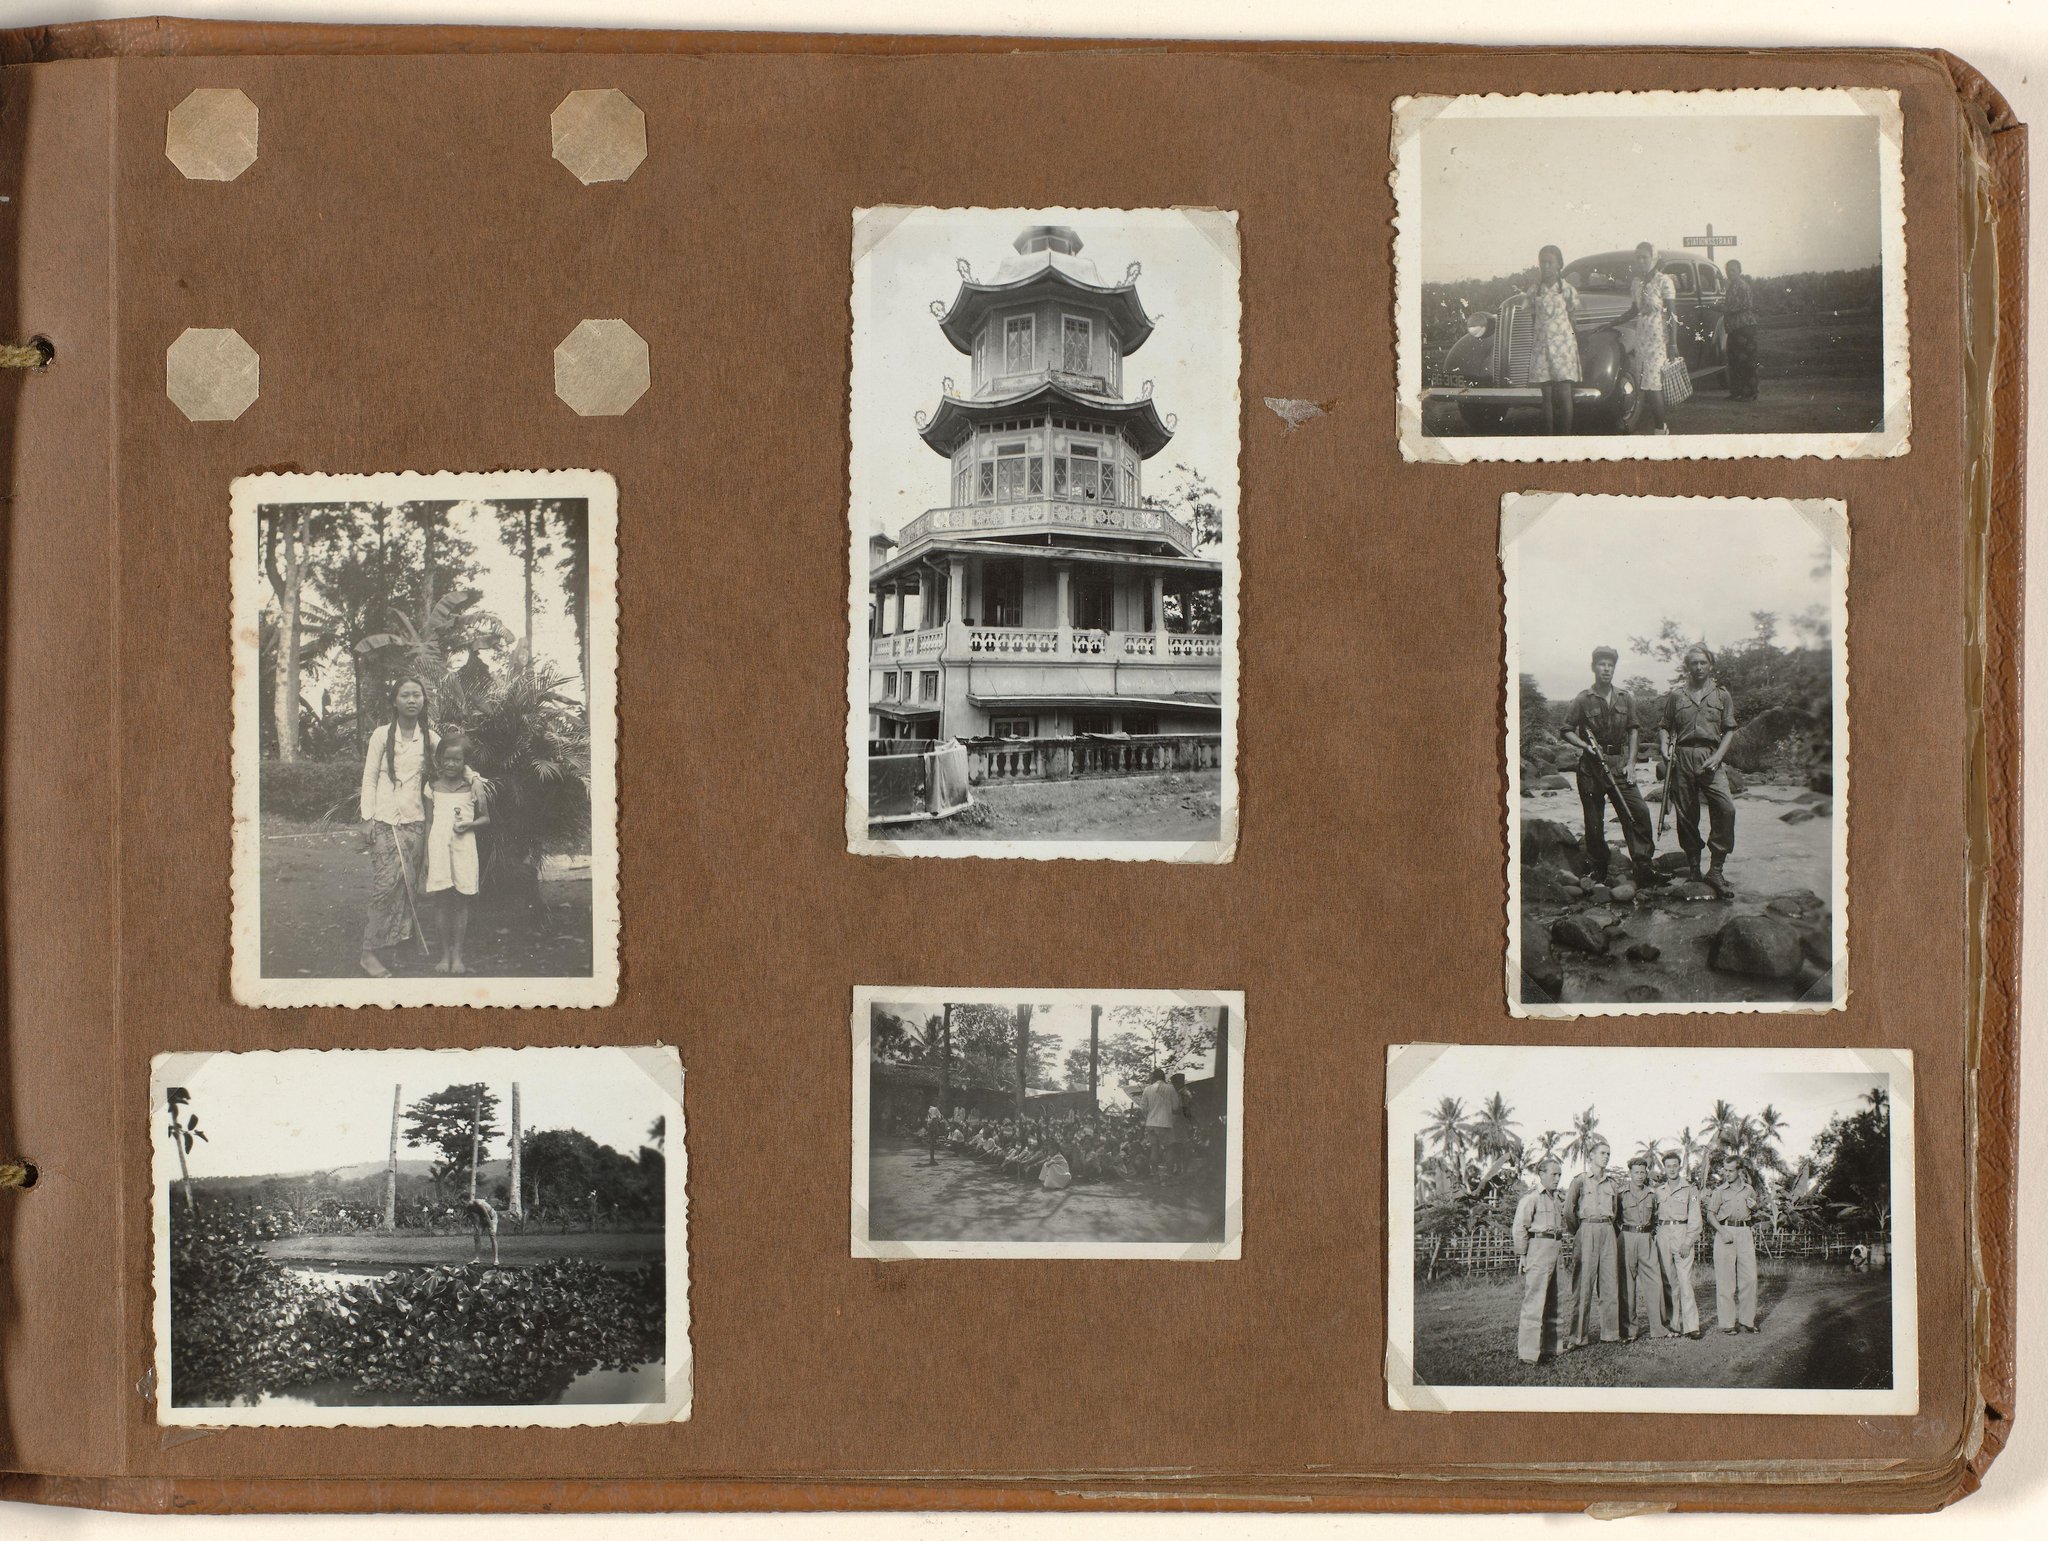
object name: photograph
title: Lokale bevolking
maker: Anonymous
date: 1948-1949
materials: paper, photographic support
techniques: photography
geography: salatiga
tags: soldiers and civilians, recreation ~ the soldier off duty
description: Het fragment van de toren is waarschijnlijk onderdeel van een oud Chinees paleiscomplex Djoen Eng, in de volksmond Tjoening, in Salatiga, waar het vijfde Regiment Infanterie op negentien januari 1948 introk als nieuw legeronderkomen. Zie ook Wim Buiting, Dagboek van Wim Buiting : pionier van 5-5 RI in Indië, Vriezeveen 2006, p.15 of documentatiemap.